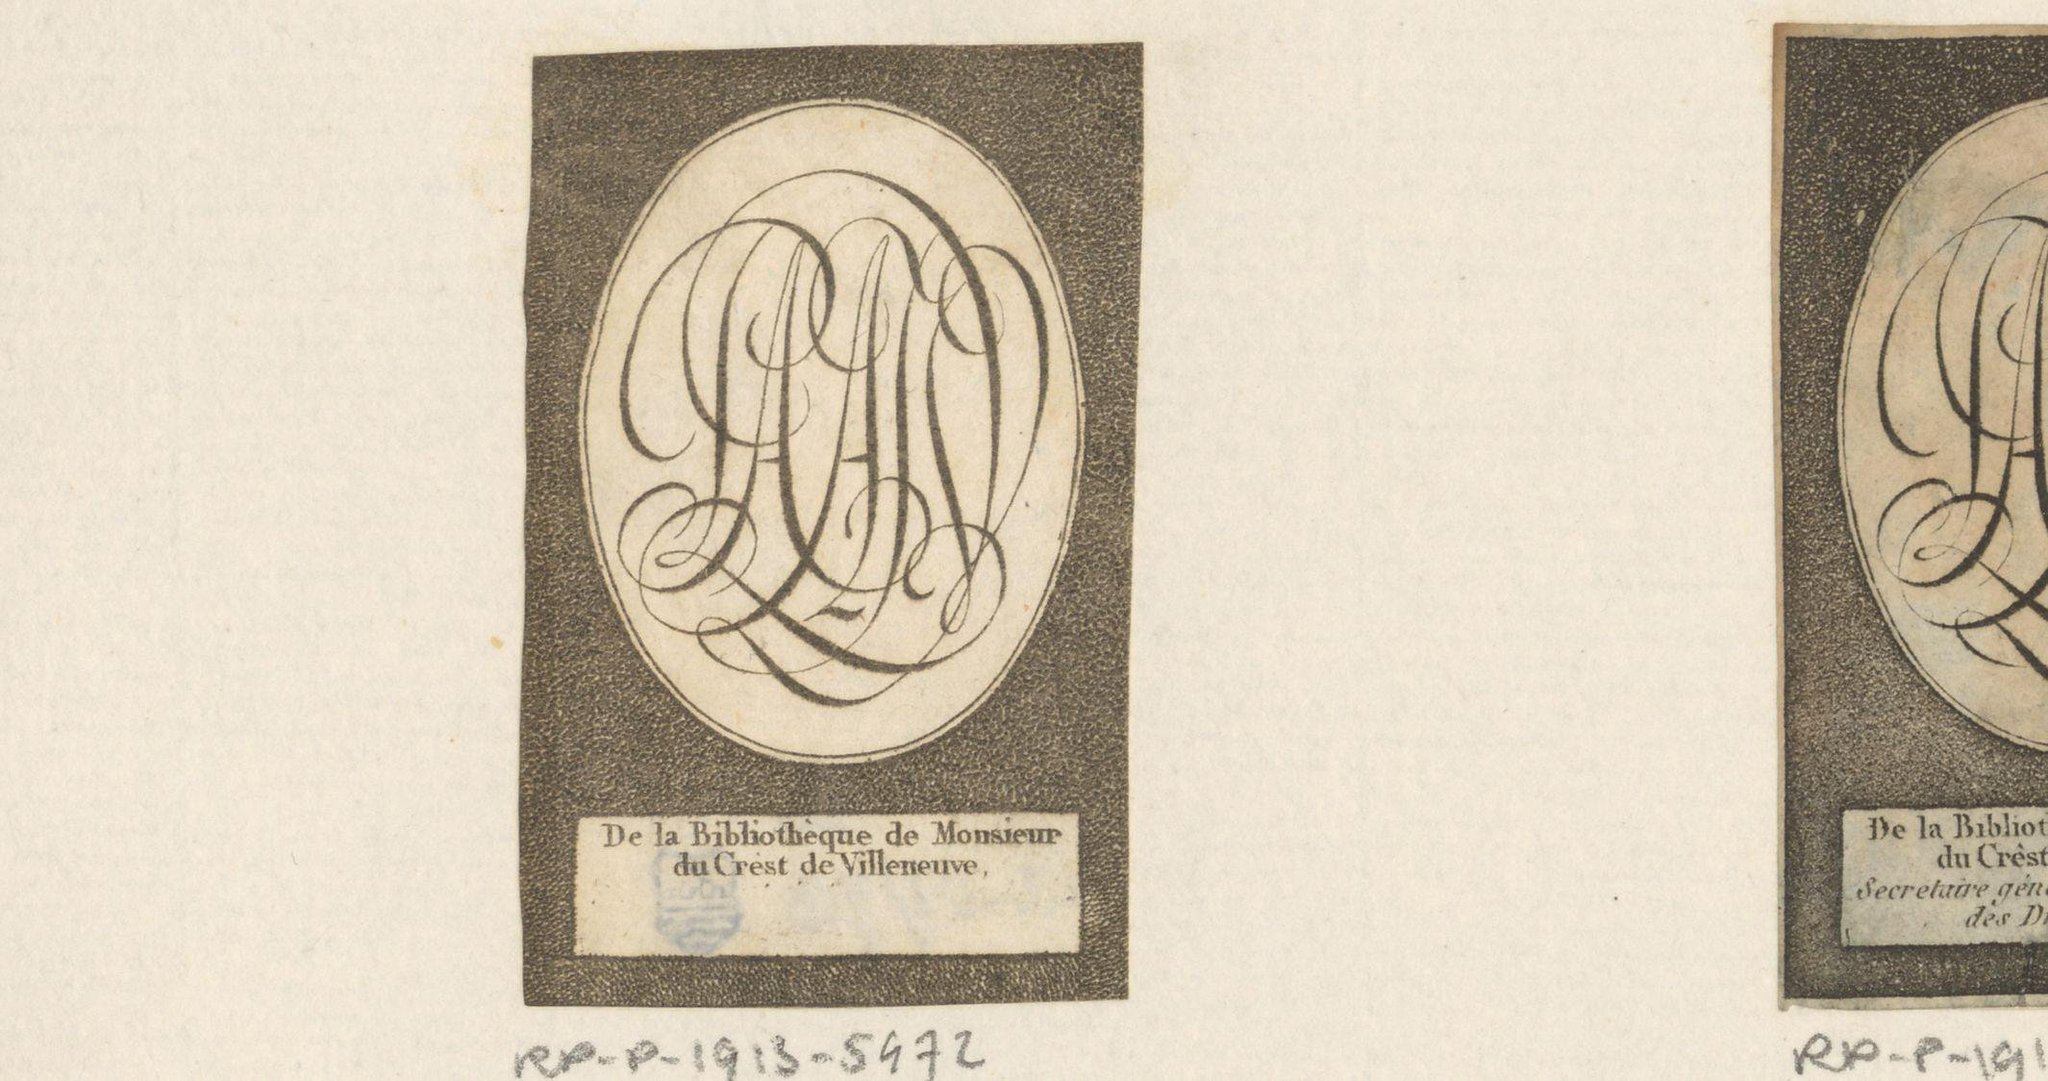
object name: bookplate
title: Ex libris van Du Crest de Villeneuve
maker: Anonymous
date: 1750-1899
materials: paper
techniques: etching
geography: france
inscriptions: collector's mark: Lugt 2233, collector's mark: Lugt 2760